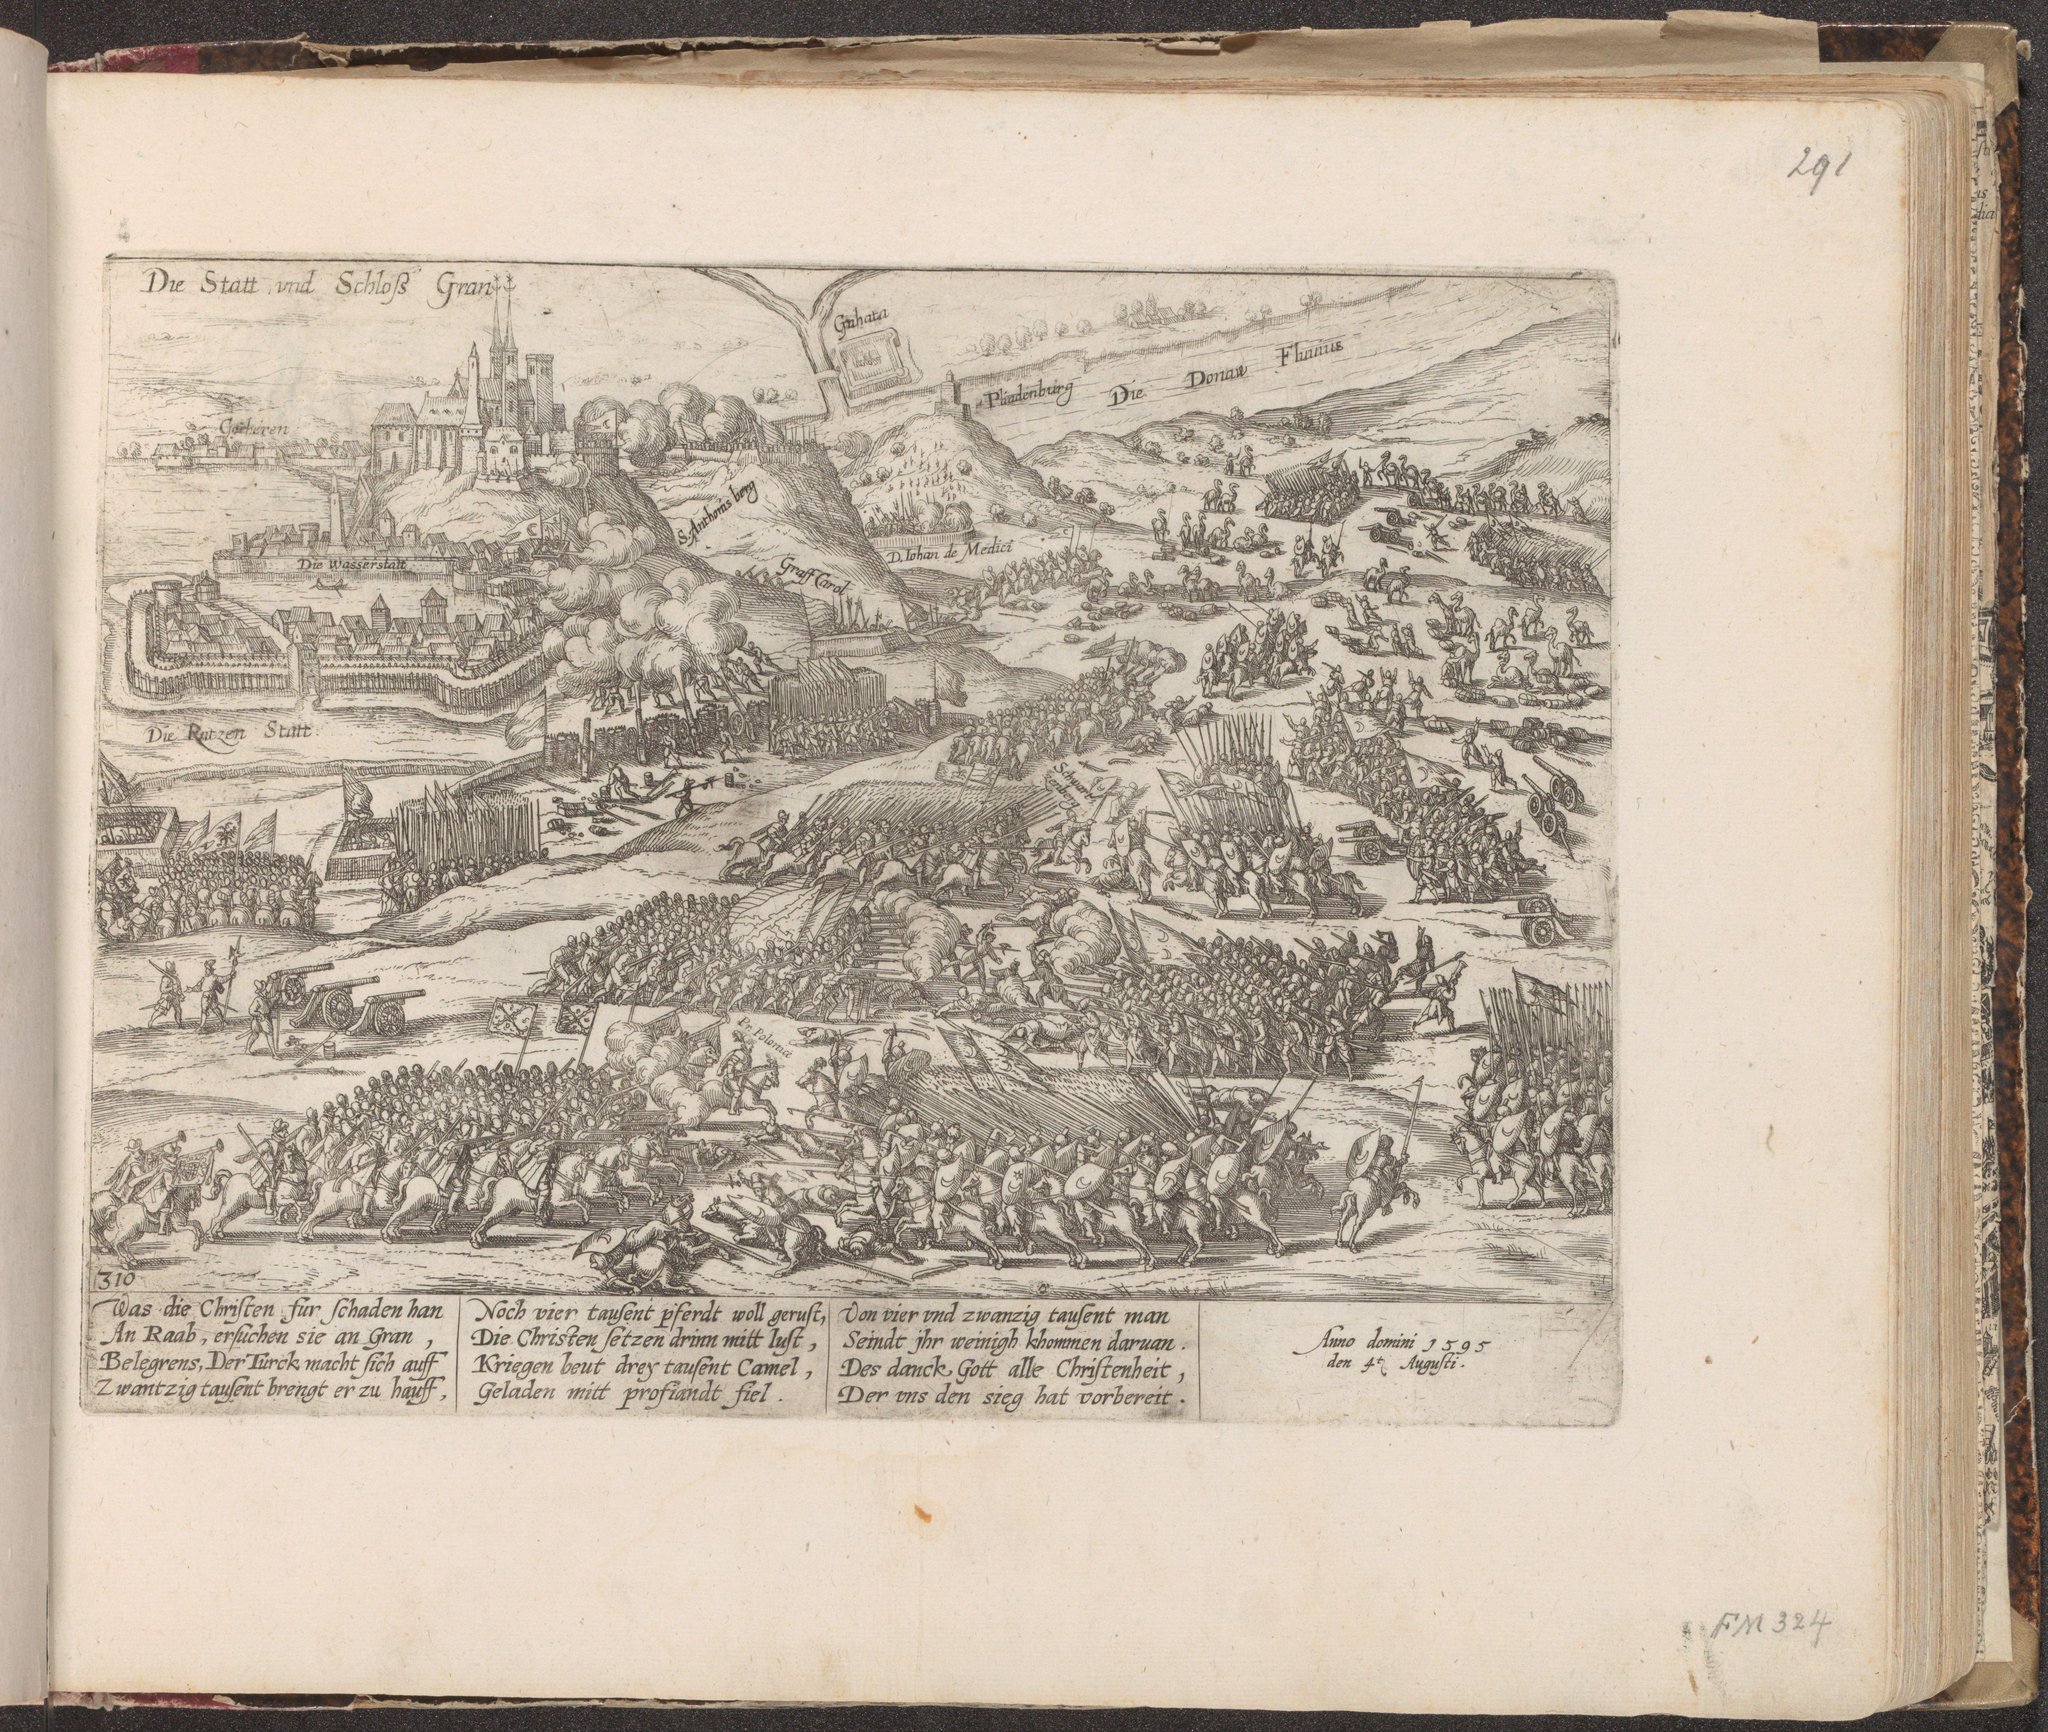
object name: print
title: Serie 10: Nederlandse en Buitenlandse Gebeurtenissen, 1587-1612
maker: frans hogenberg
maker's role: print maker, publisher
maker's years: 1538-1590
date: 1595-1597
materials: paper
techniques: etching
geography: cologne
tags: battle, fighting in general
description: Inname van Gran (Esztergom) door de Christenen, 4 augustus 1595. Veldslag voor de stad tussen de Christelijke en Turkse legers. In de verte de stad Gran met het kasteel aan de Donau. Met onderschrift van 12 regels in het Duits. Linksonder genummerd: 310. De prent maakt deel uit van een album.